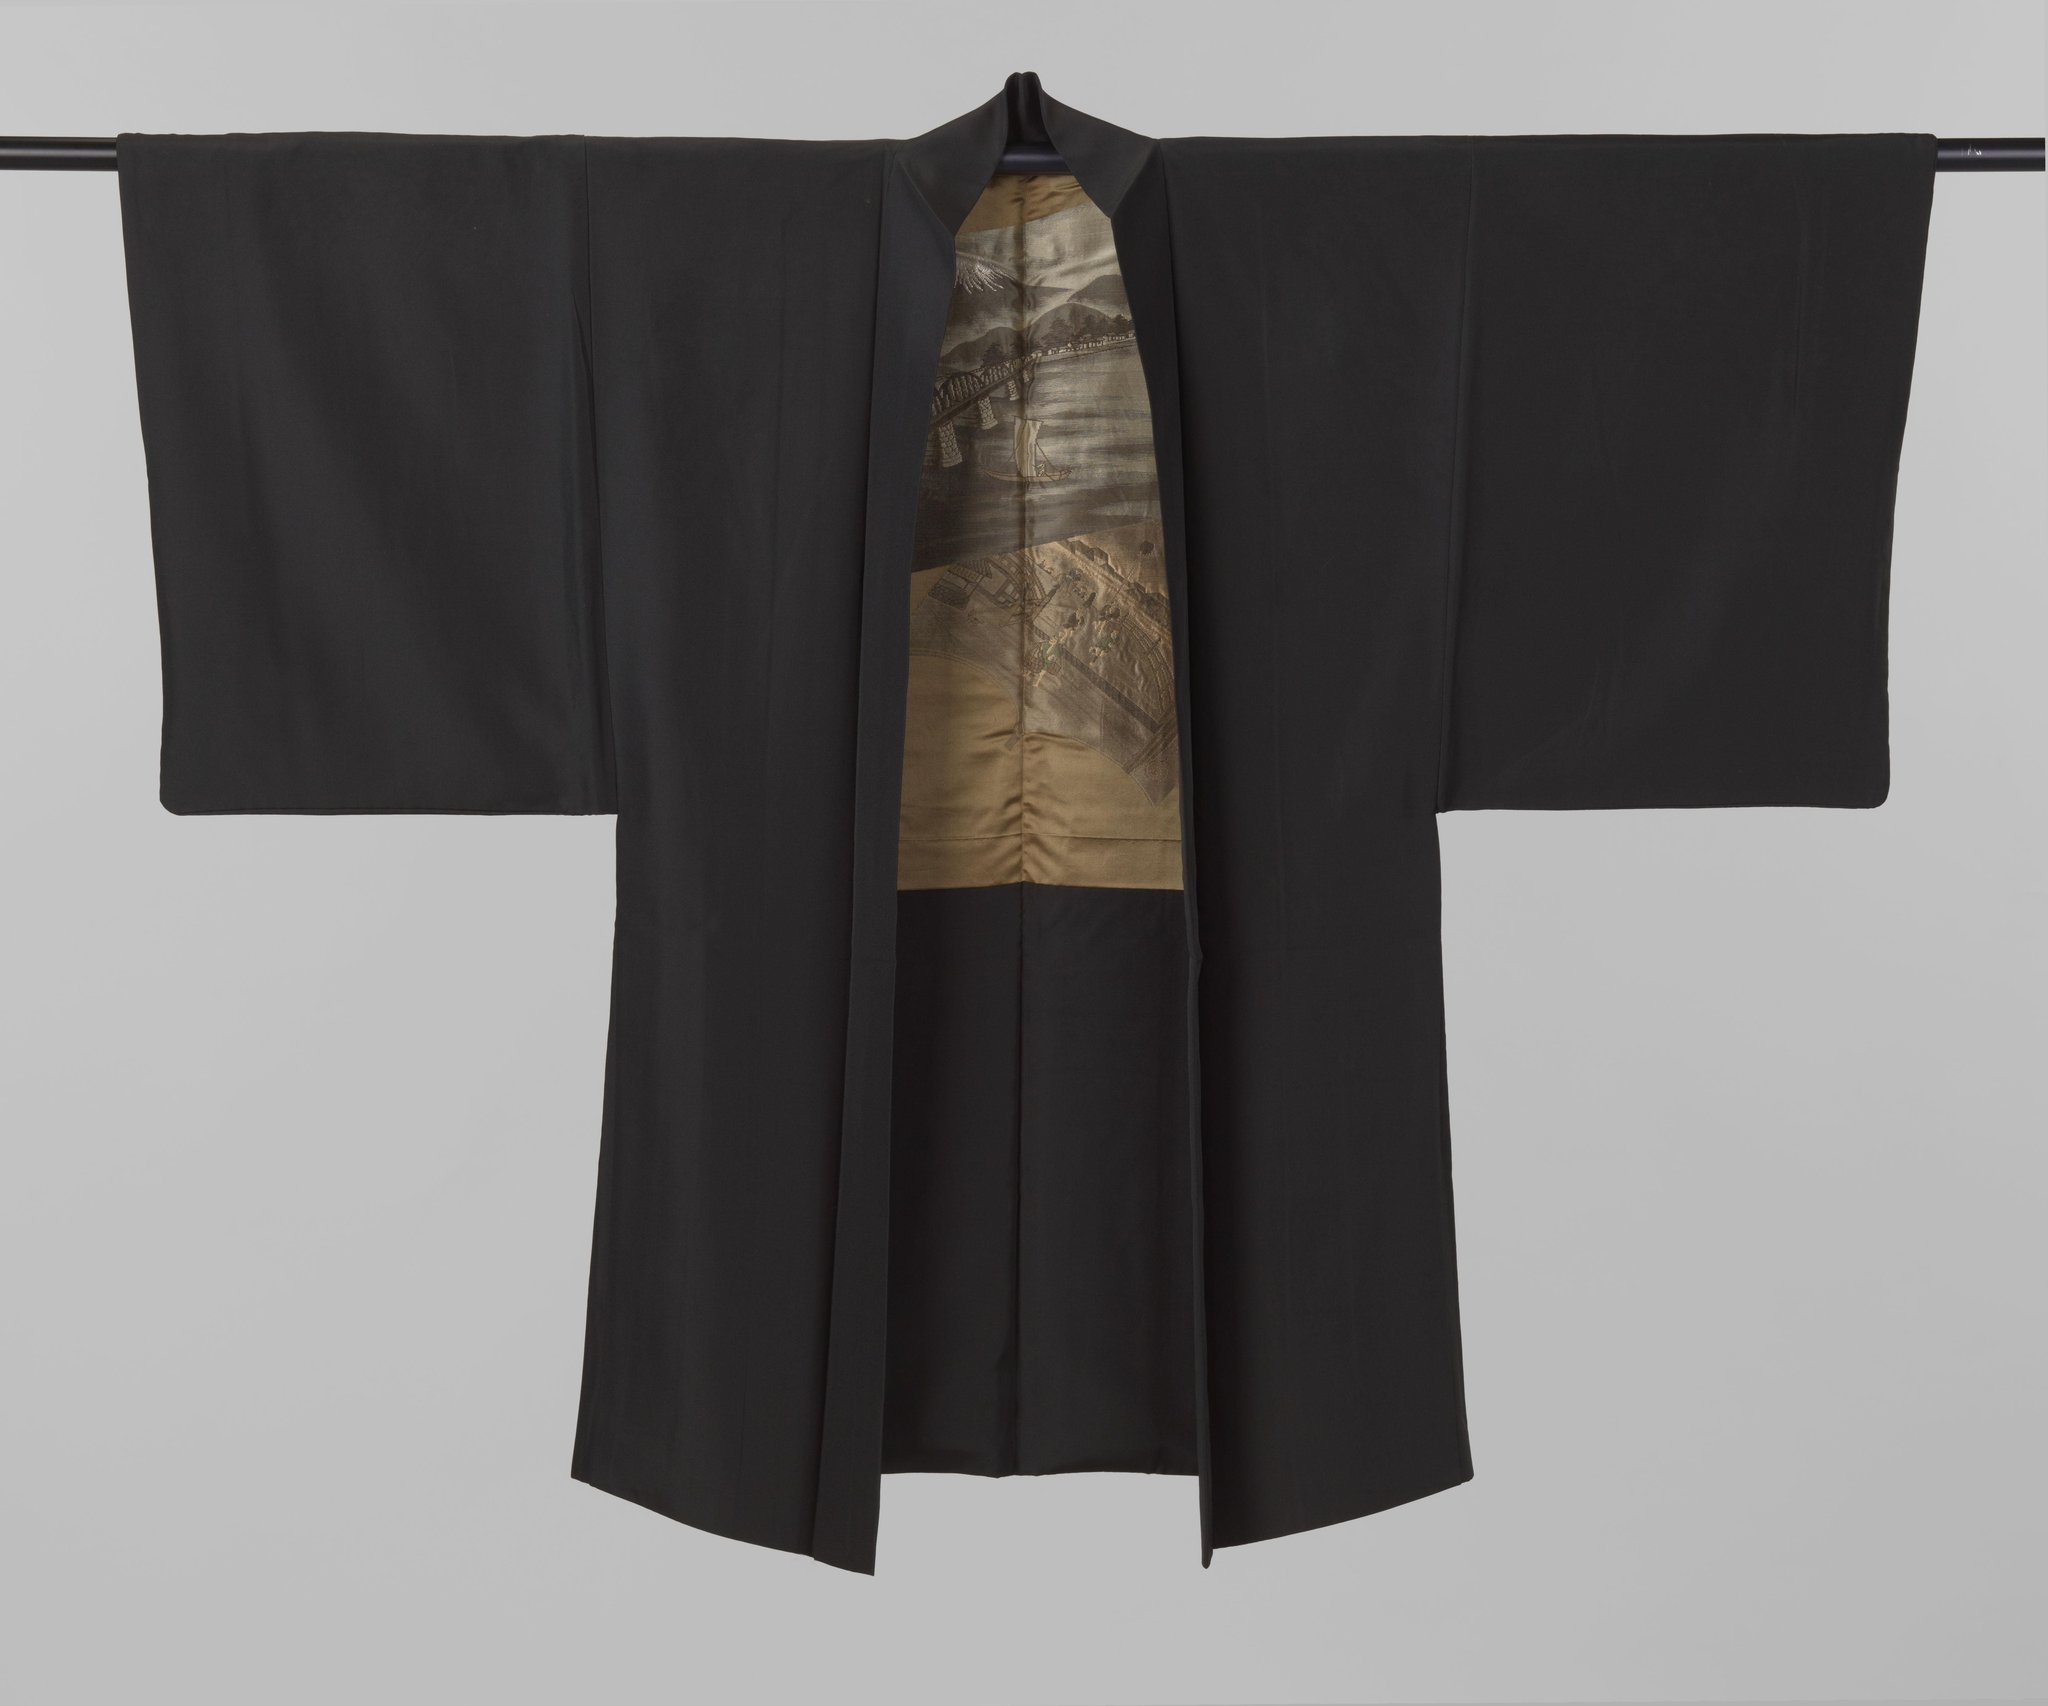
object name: kimono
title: Mannen haori met de Nihonbashi brug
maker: Anonymous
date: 1920-1940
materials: silk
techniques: weave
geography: japan